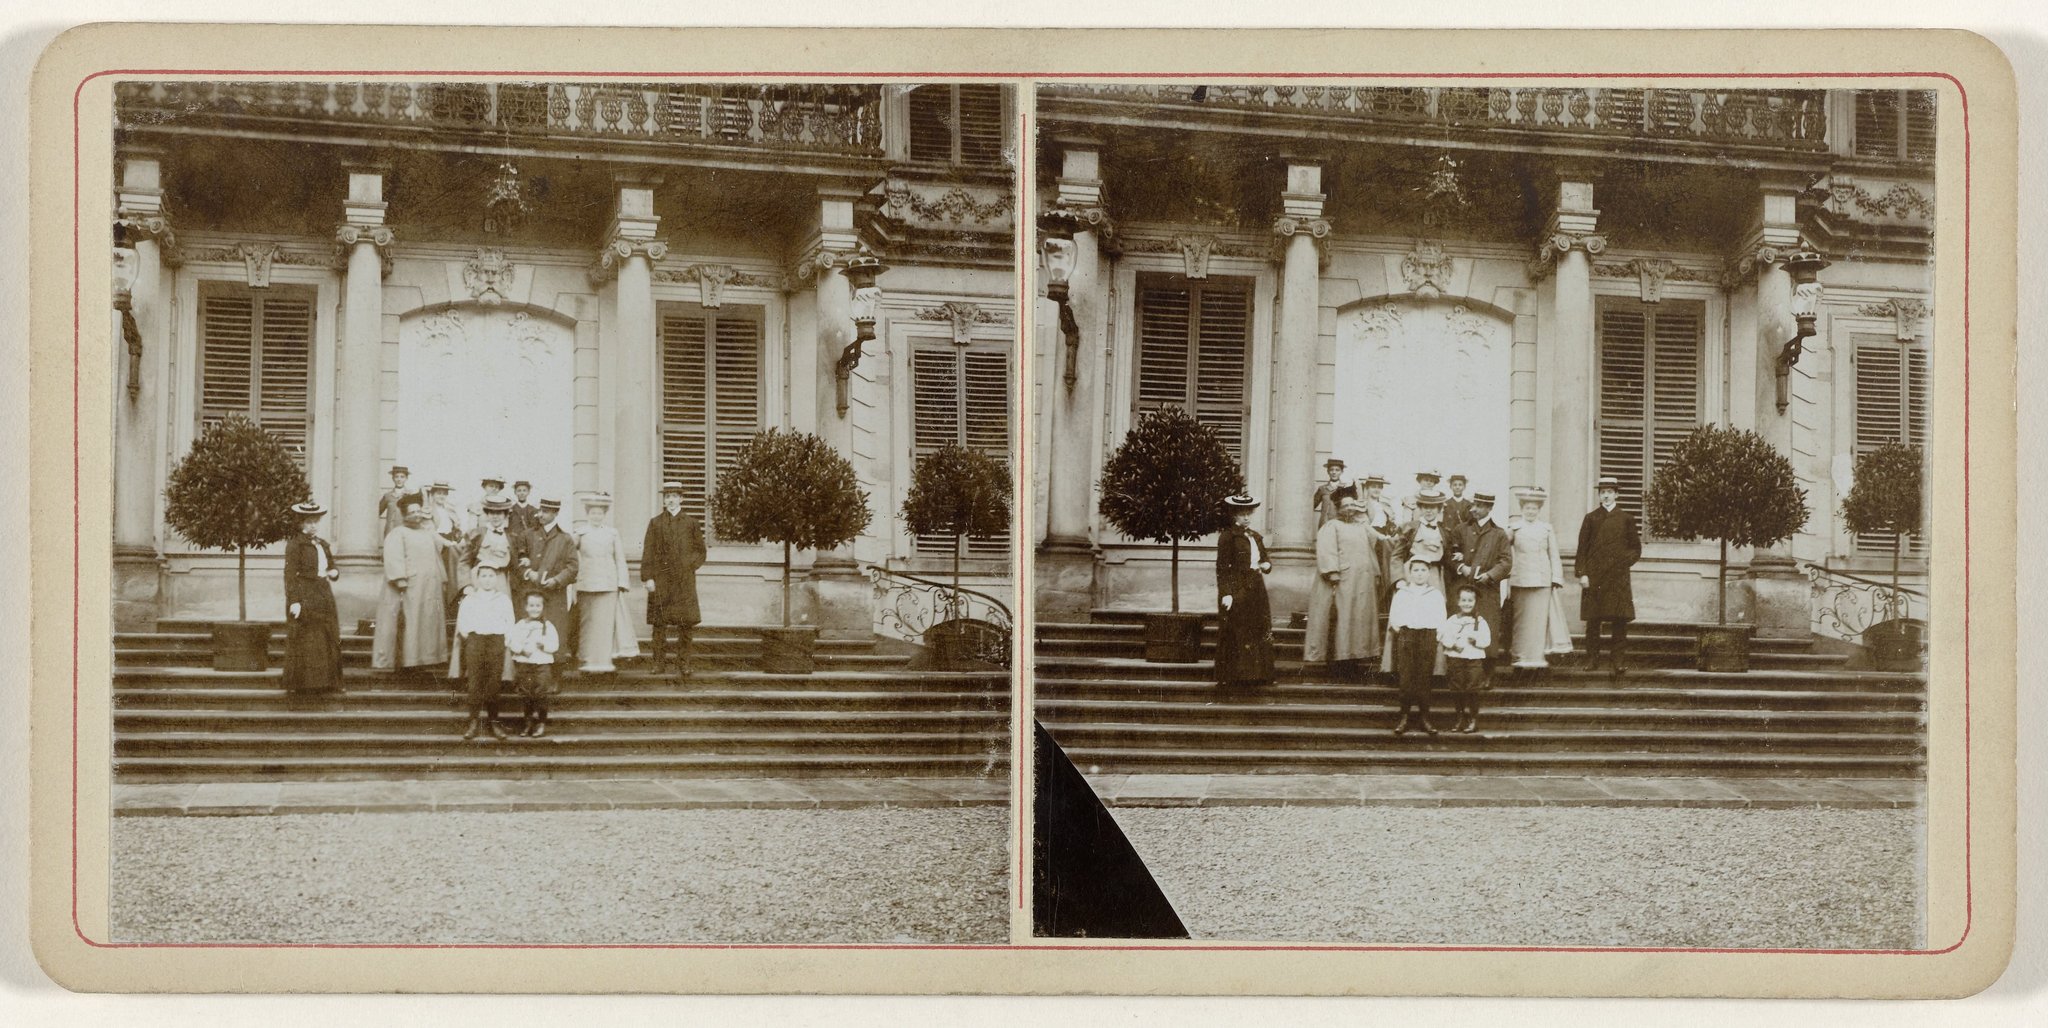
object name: stereograph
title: Wilhelmsthal bij Cassel, juli 1903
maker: geldolph adriaan kessler (dolph)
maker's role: fotograaf, industrieel, voetballer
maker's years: 1884-1945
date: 1903-1907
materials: paper, photographic support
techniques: collodion silver print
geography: kassel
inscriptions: title: ‘Wilhelmsthal bij Cassel, juli 1903’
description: Portret van de familie Kessler op de trappen van het landhuis Wilhelmsthal in Kassel.